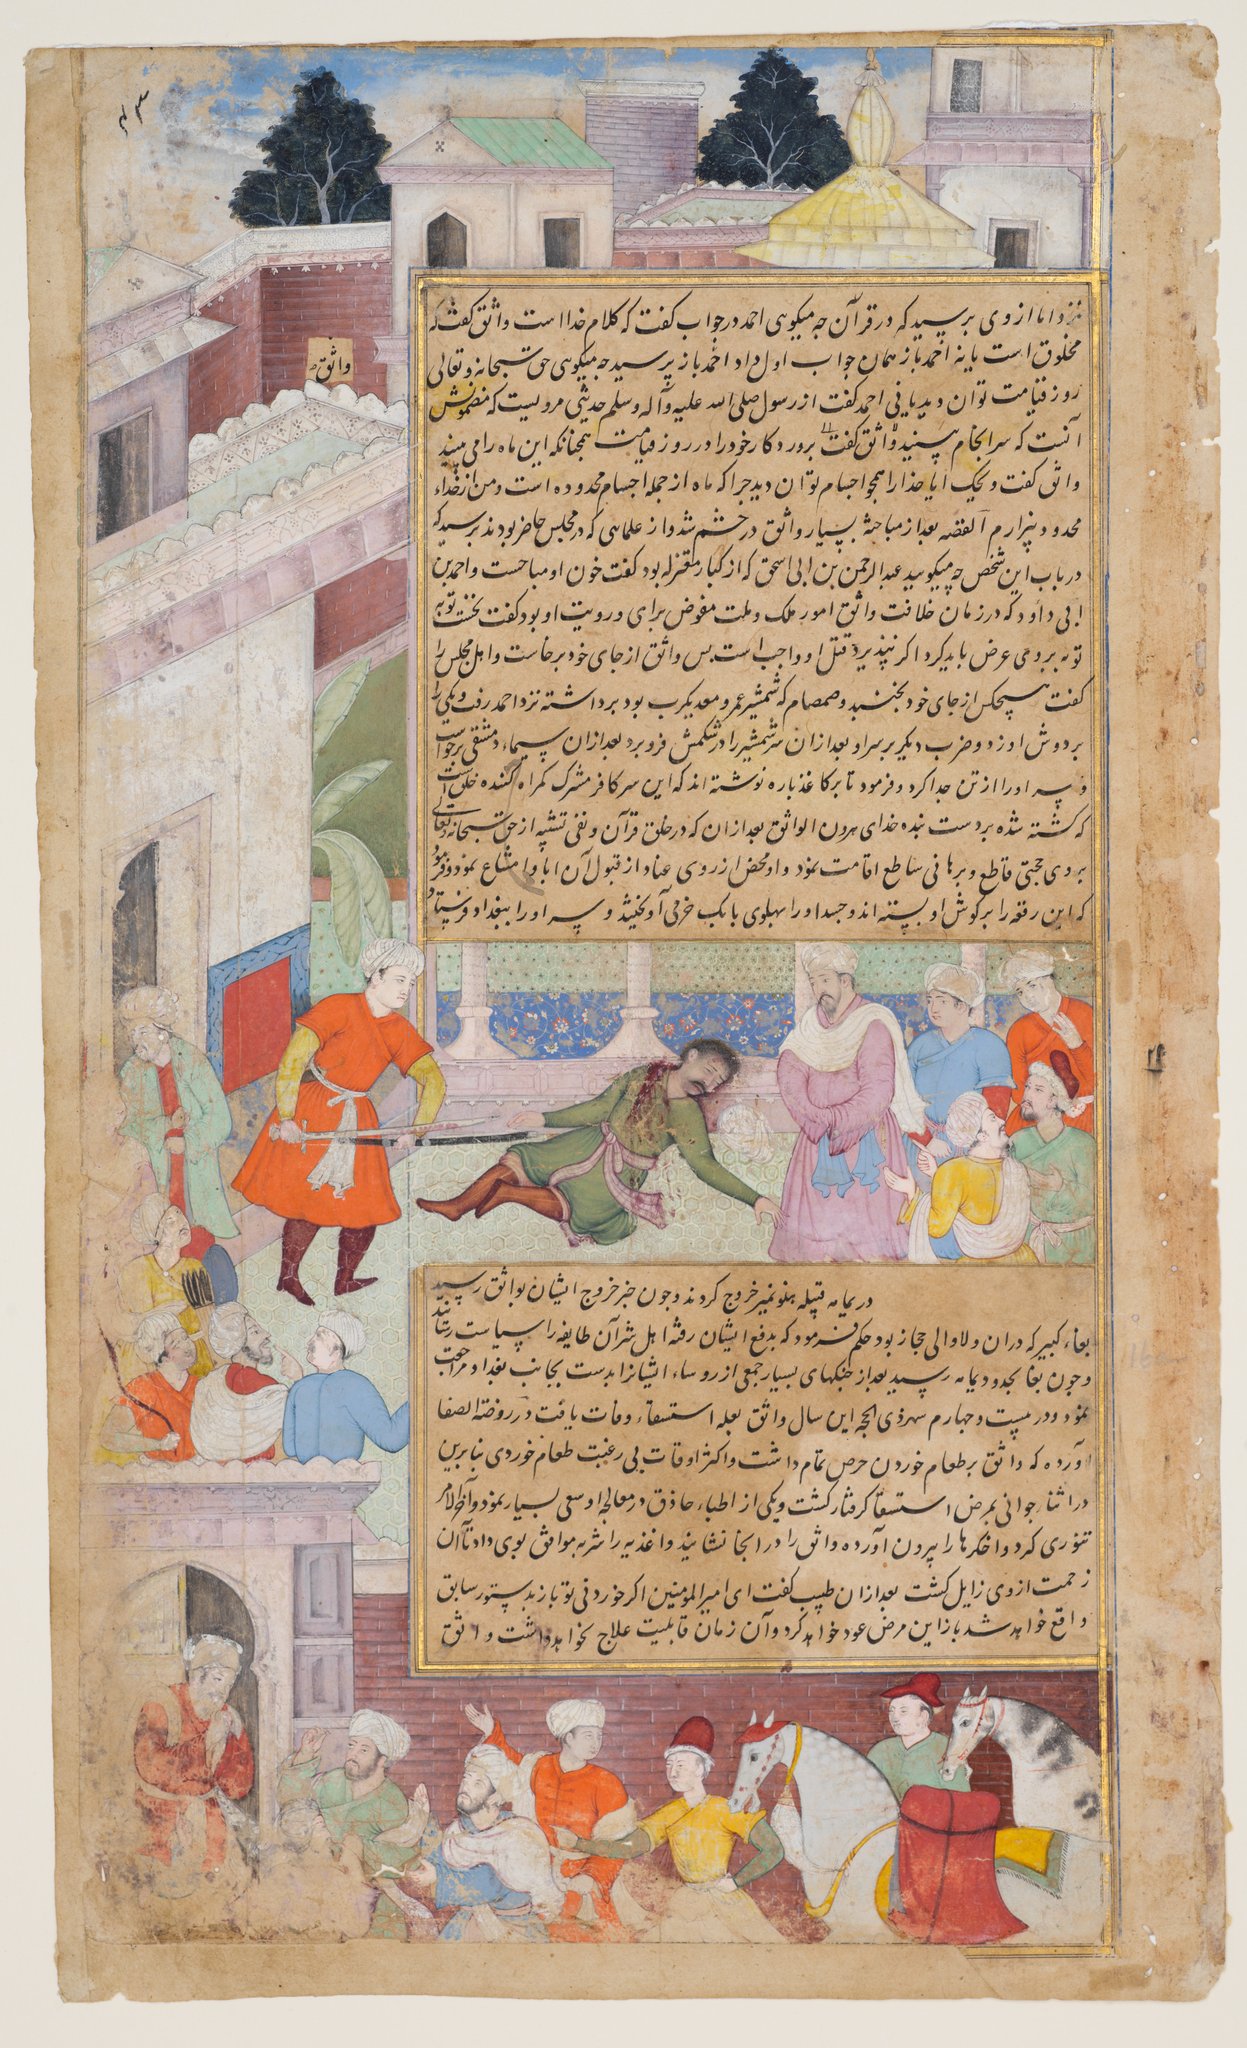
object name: folio from an illustrated manuscript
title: "Caliph Al-Wathiq Killing the Rebel Ahmad Ibn Nasr", Folio from the Tarikh-i ‘Alfi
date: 1592-1594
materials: gold, ink, paper, watercolor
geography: india